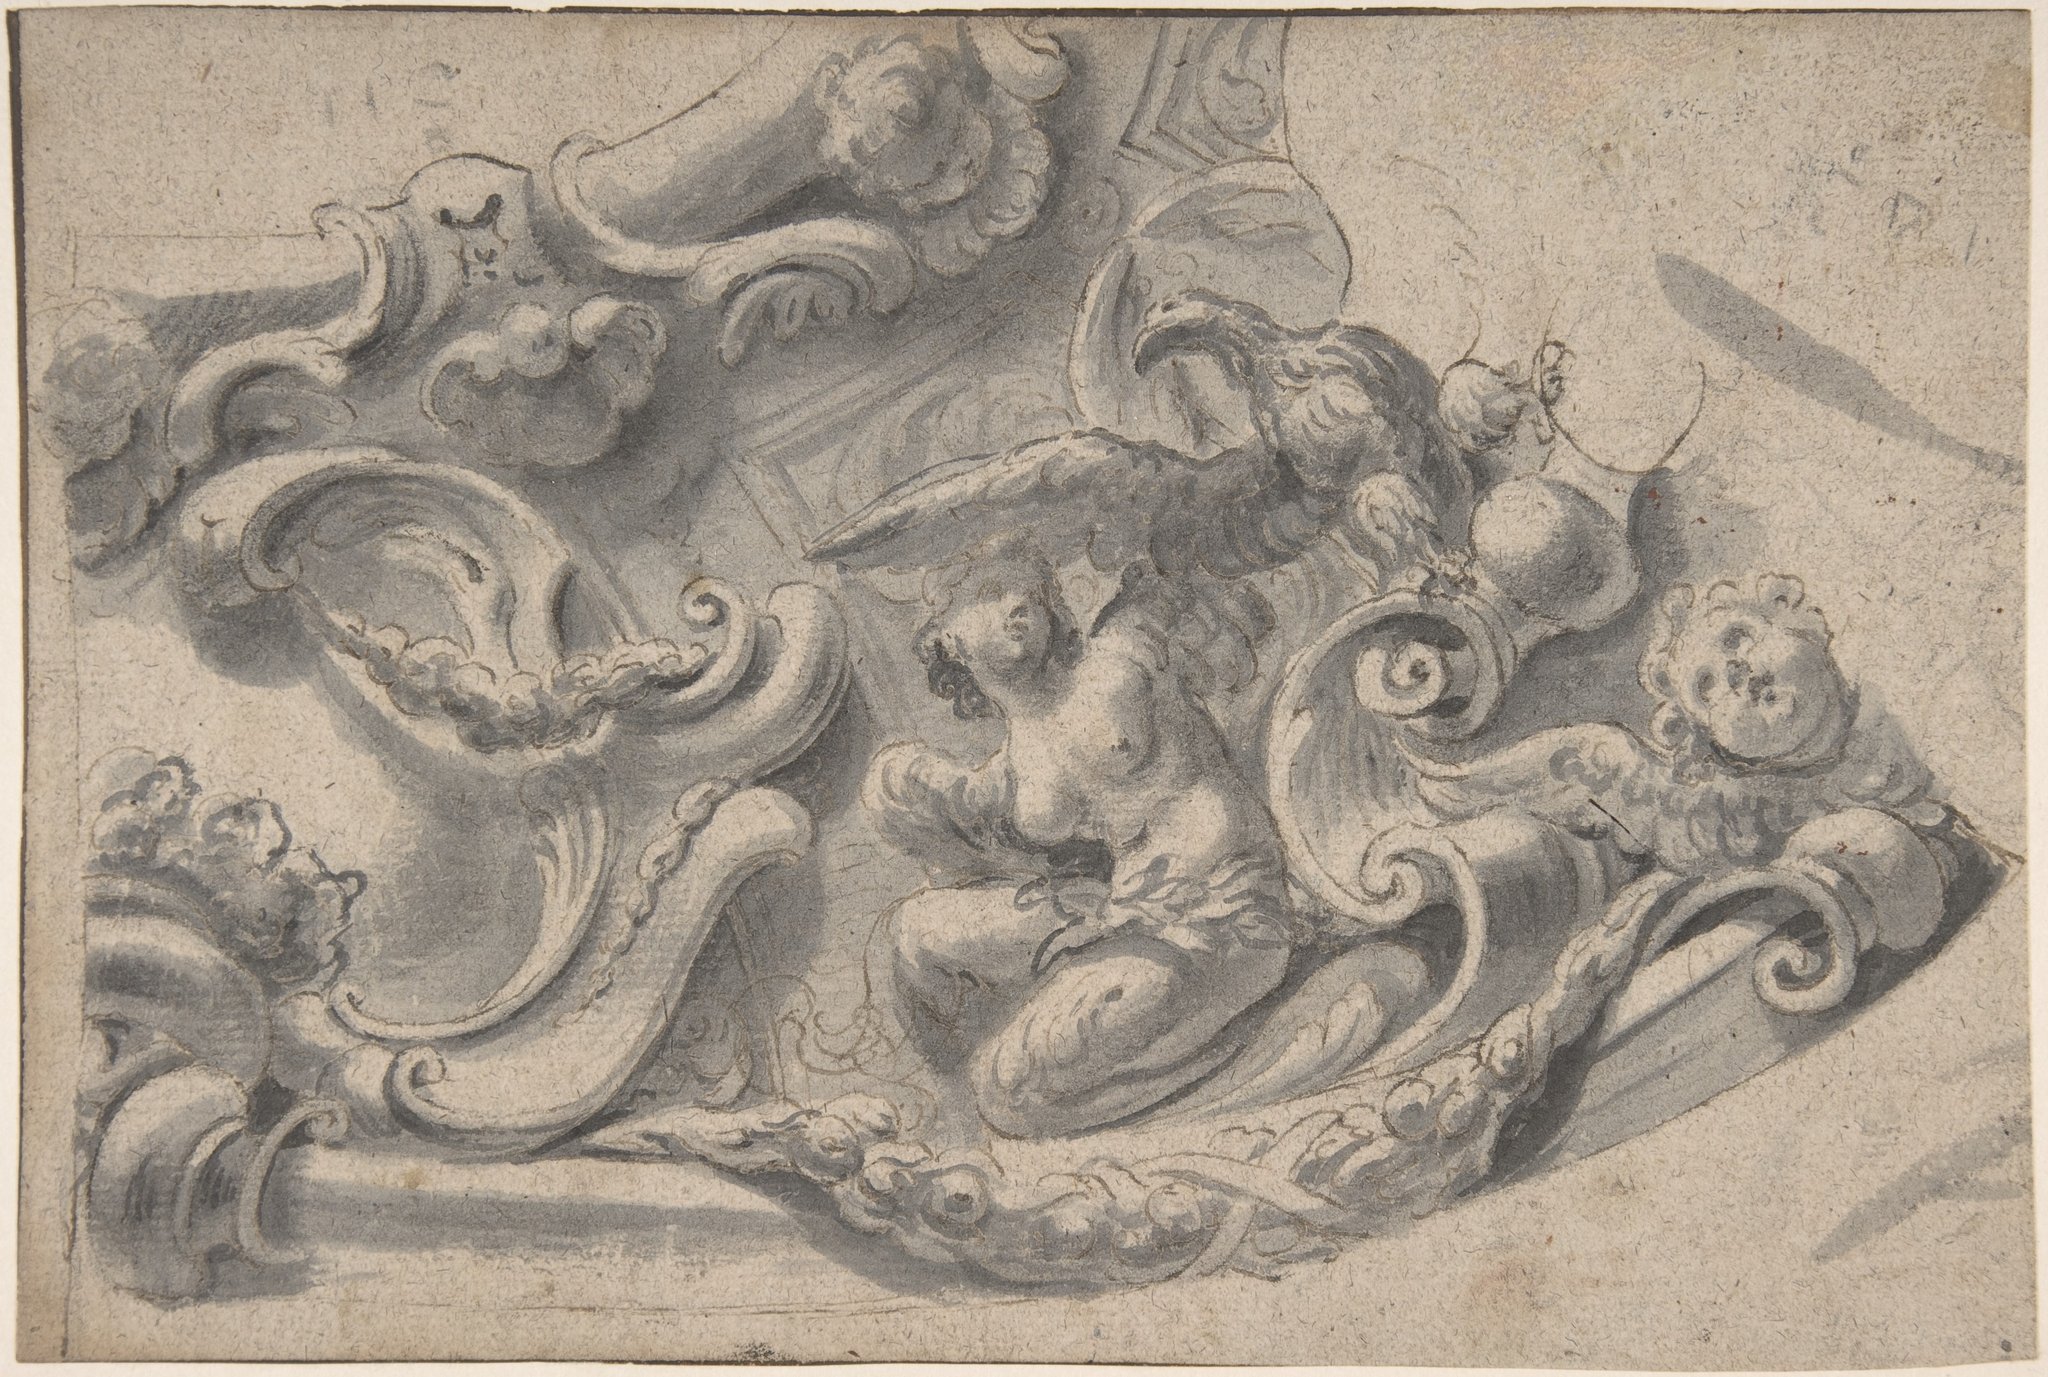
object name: drawing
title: Design for a Decorative Cornice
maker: anonymous, italian, 18th century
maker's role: artist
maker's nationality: italian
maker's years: 1700-1800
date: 1701-1800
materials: chalk, ink, paper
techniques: brush, pen, wash